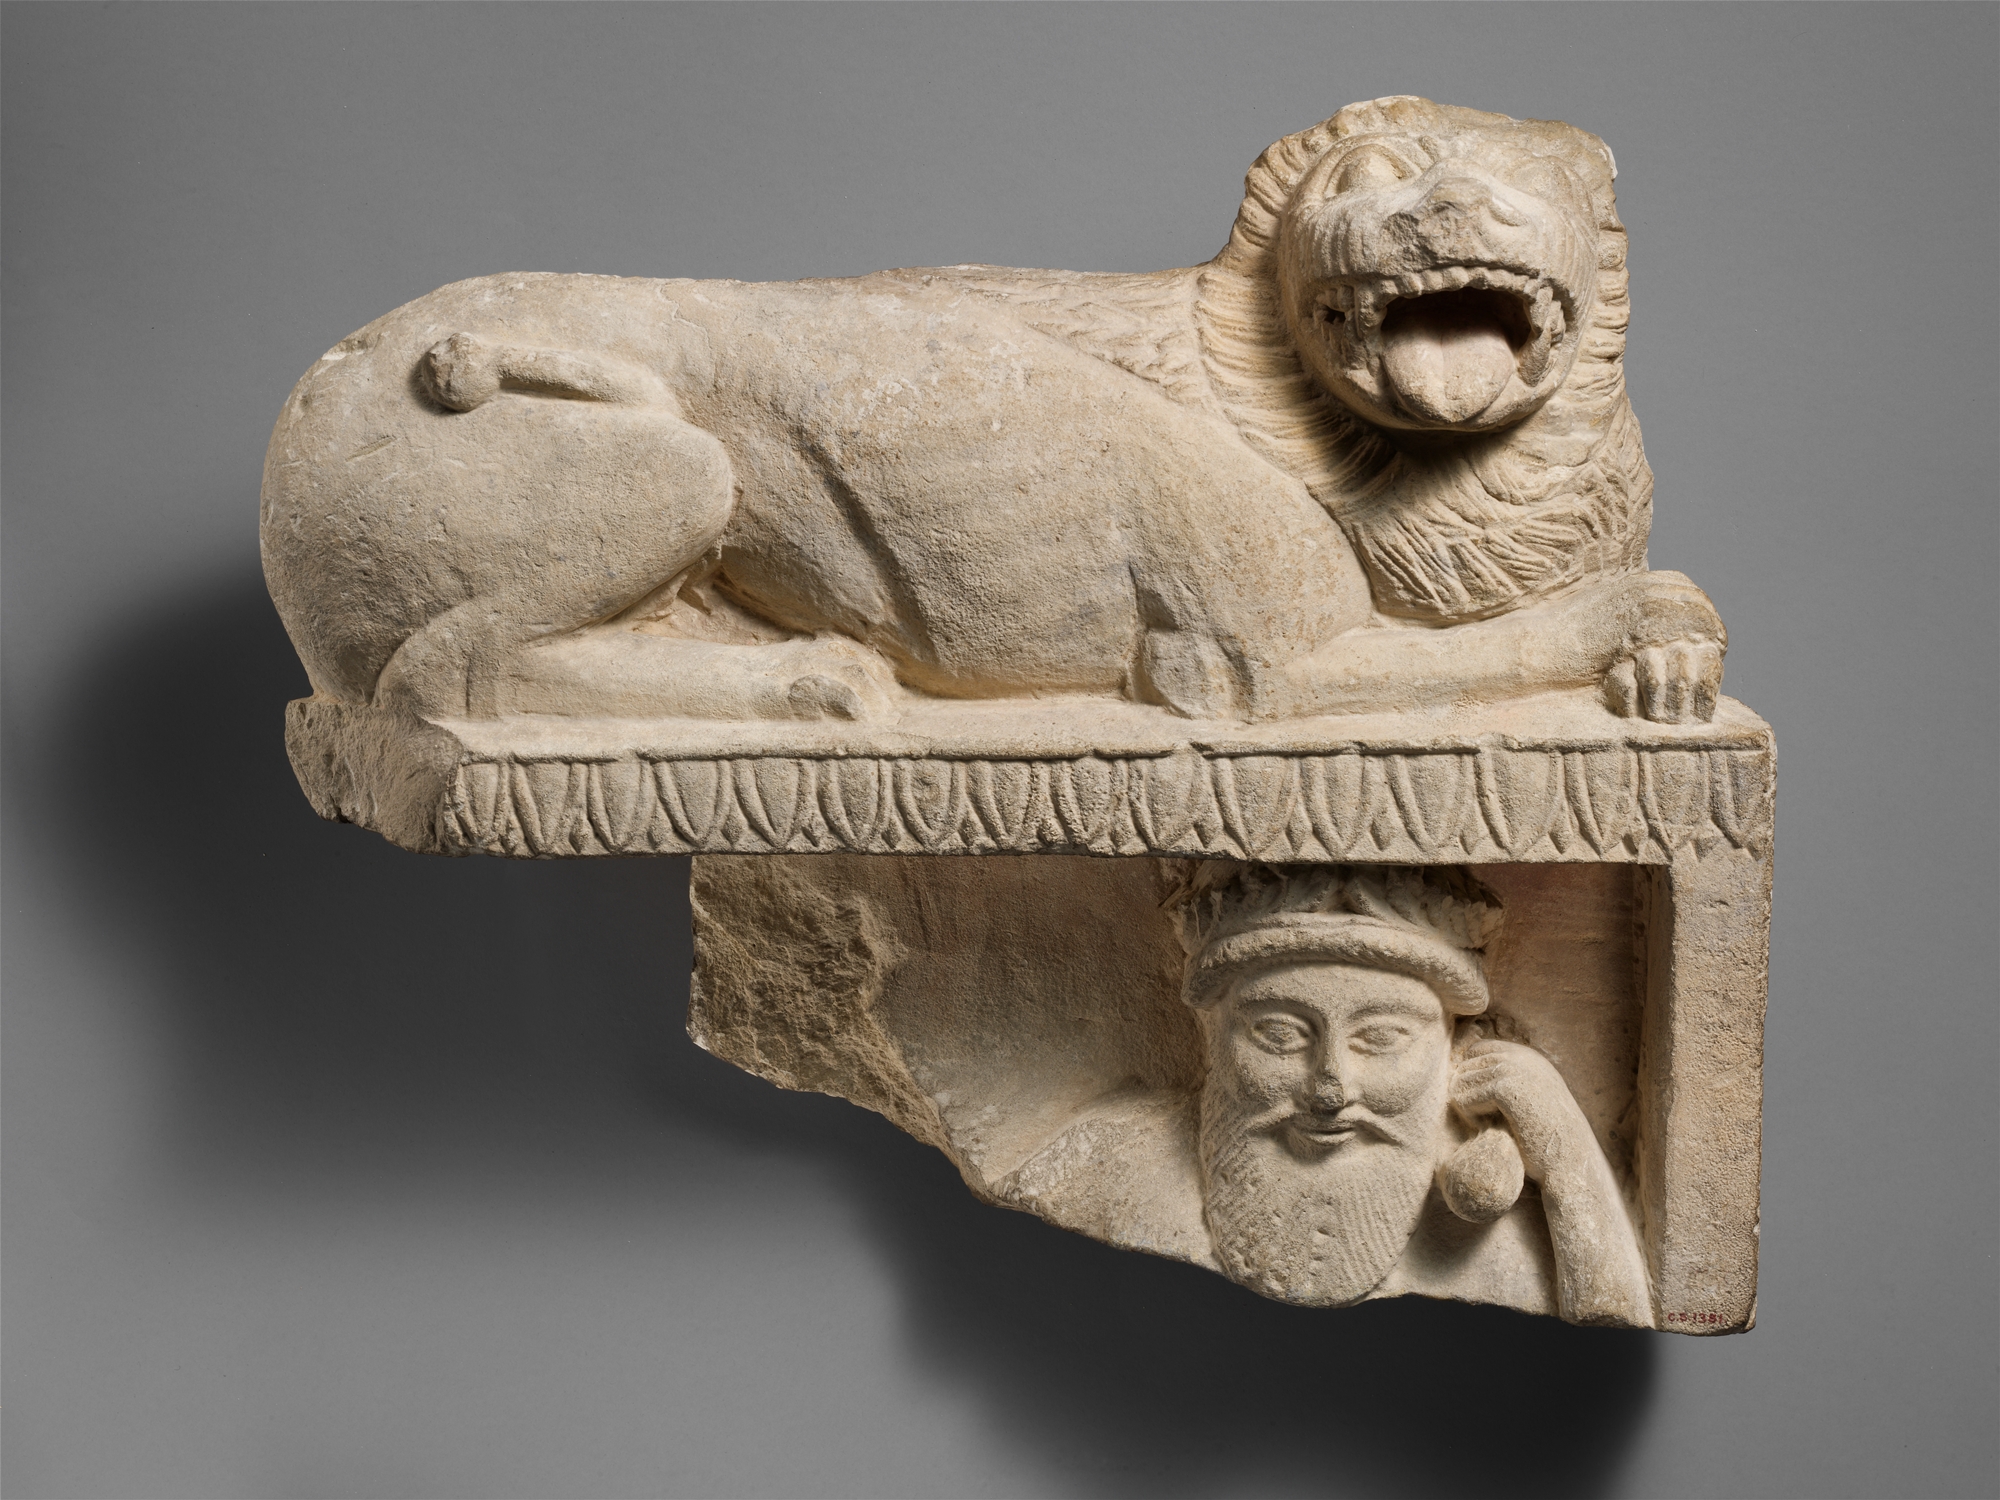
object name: grave relief of man and lion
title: Limestone finial of a funerary stele with a recumbent lion and a banquet scene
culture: cypriot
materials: limestone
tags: men,lions